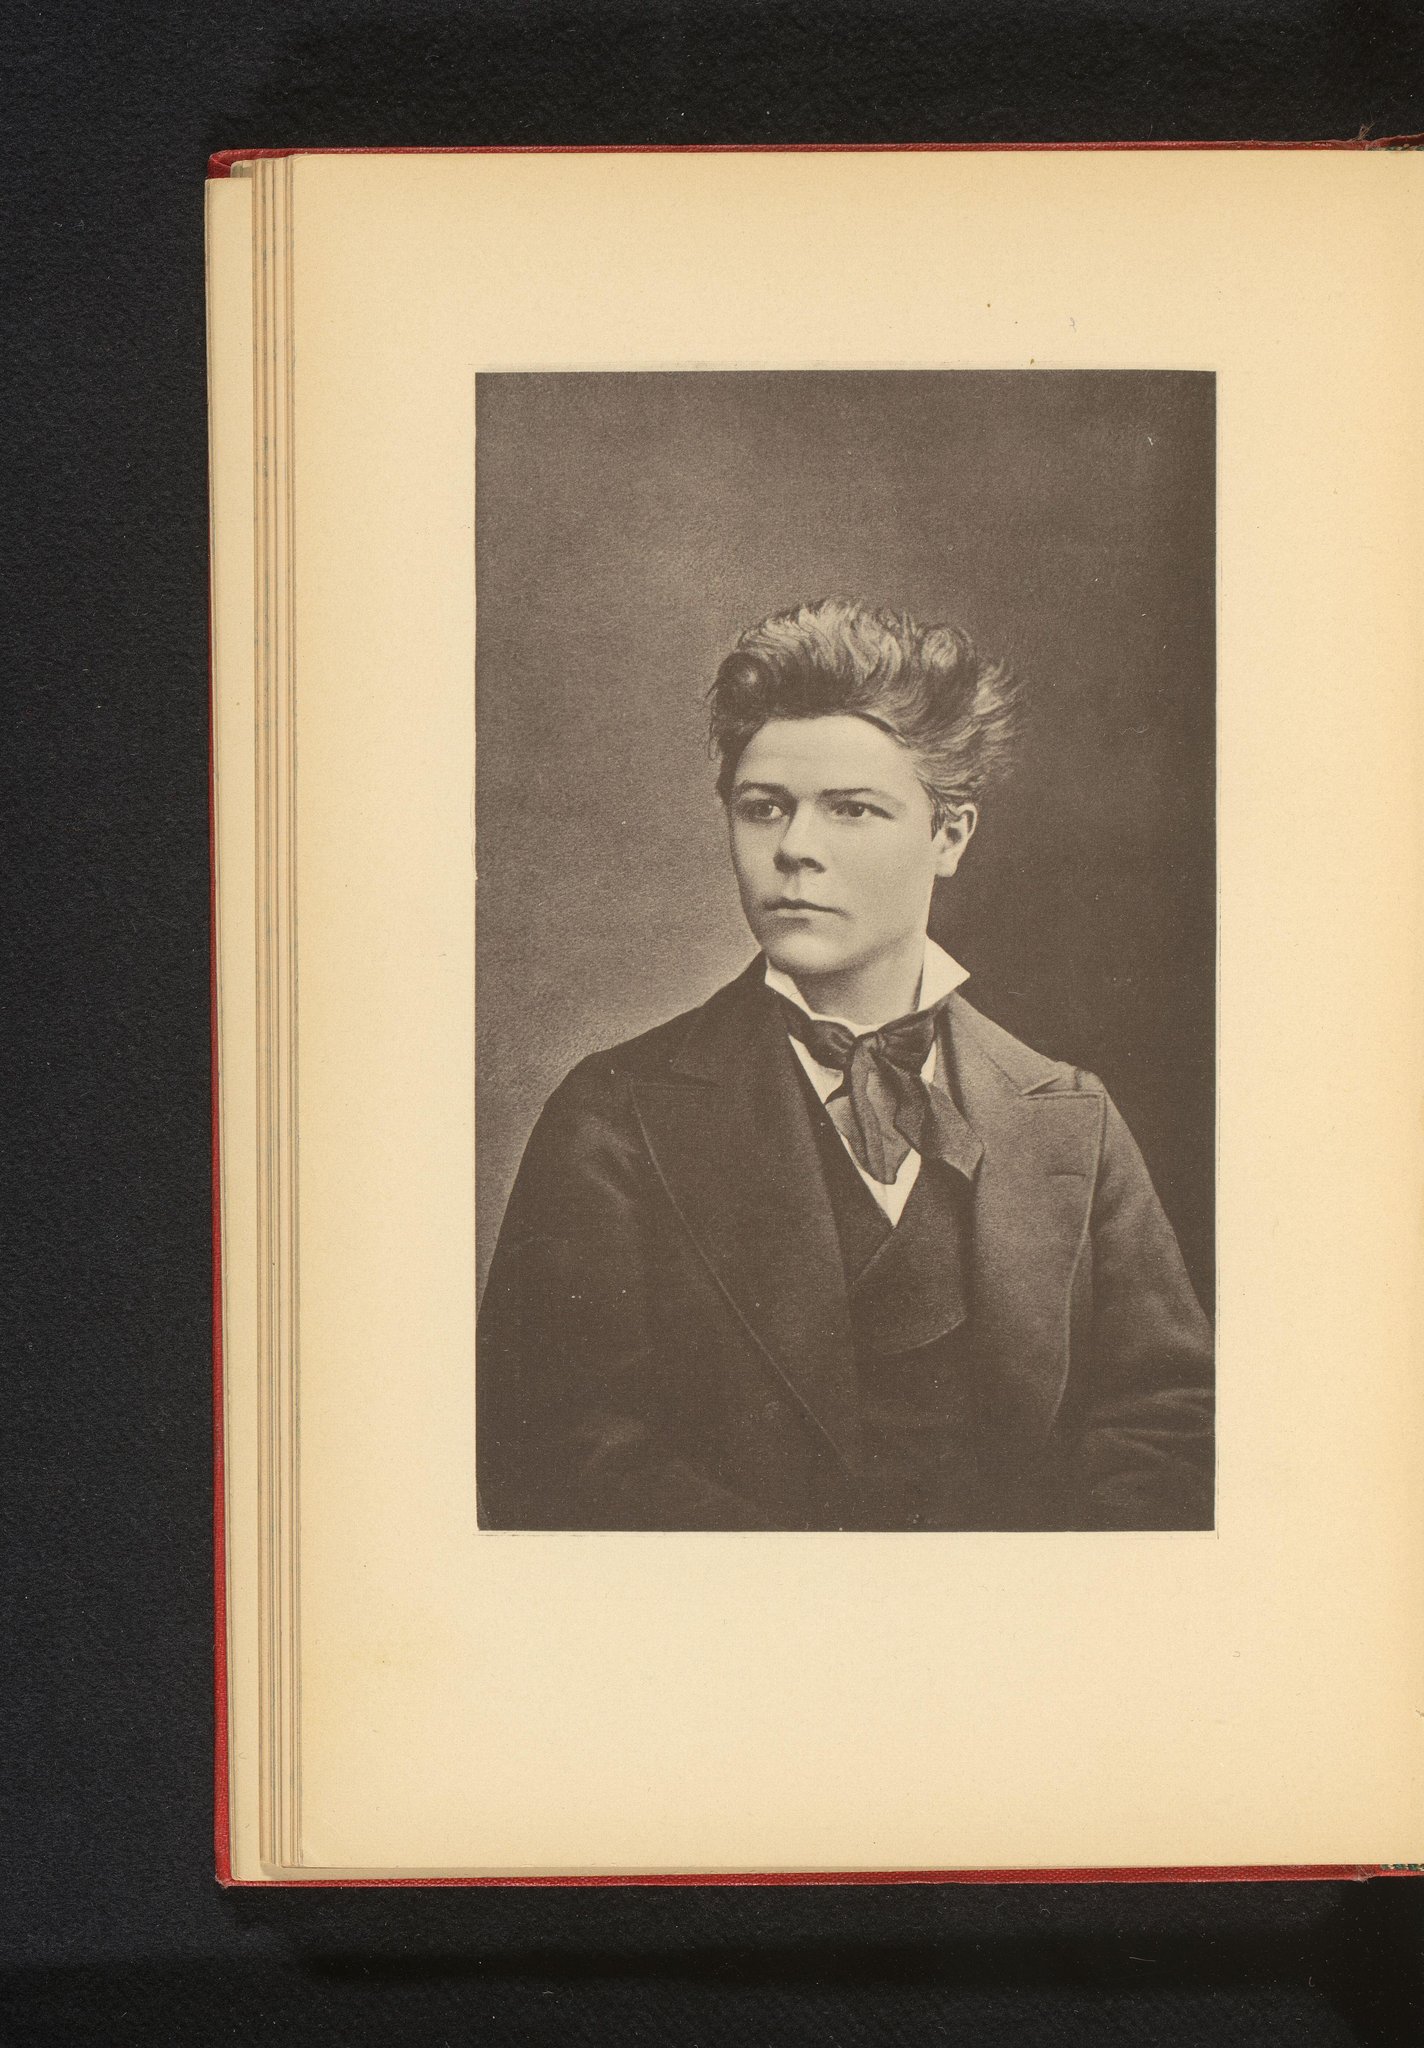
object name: page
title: Portret van Robert Stigell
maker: Anonymous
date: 1873-1883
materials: paper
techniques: photograph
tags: sculptor, portrait, self-portrait of sculptor